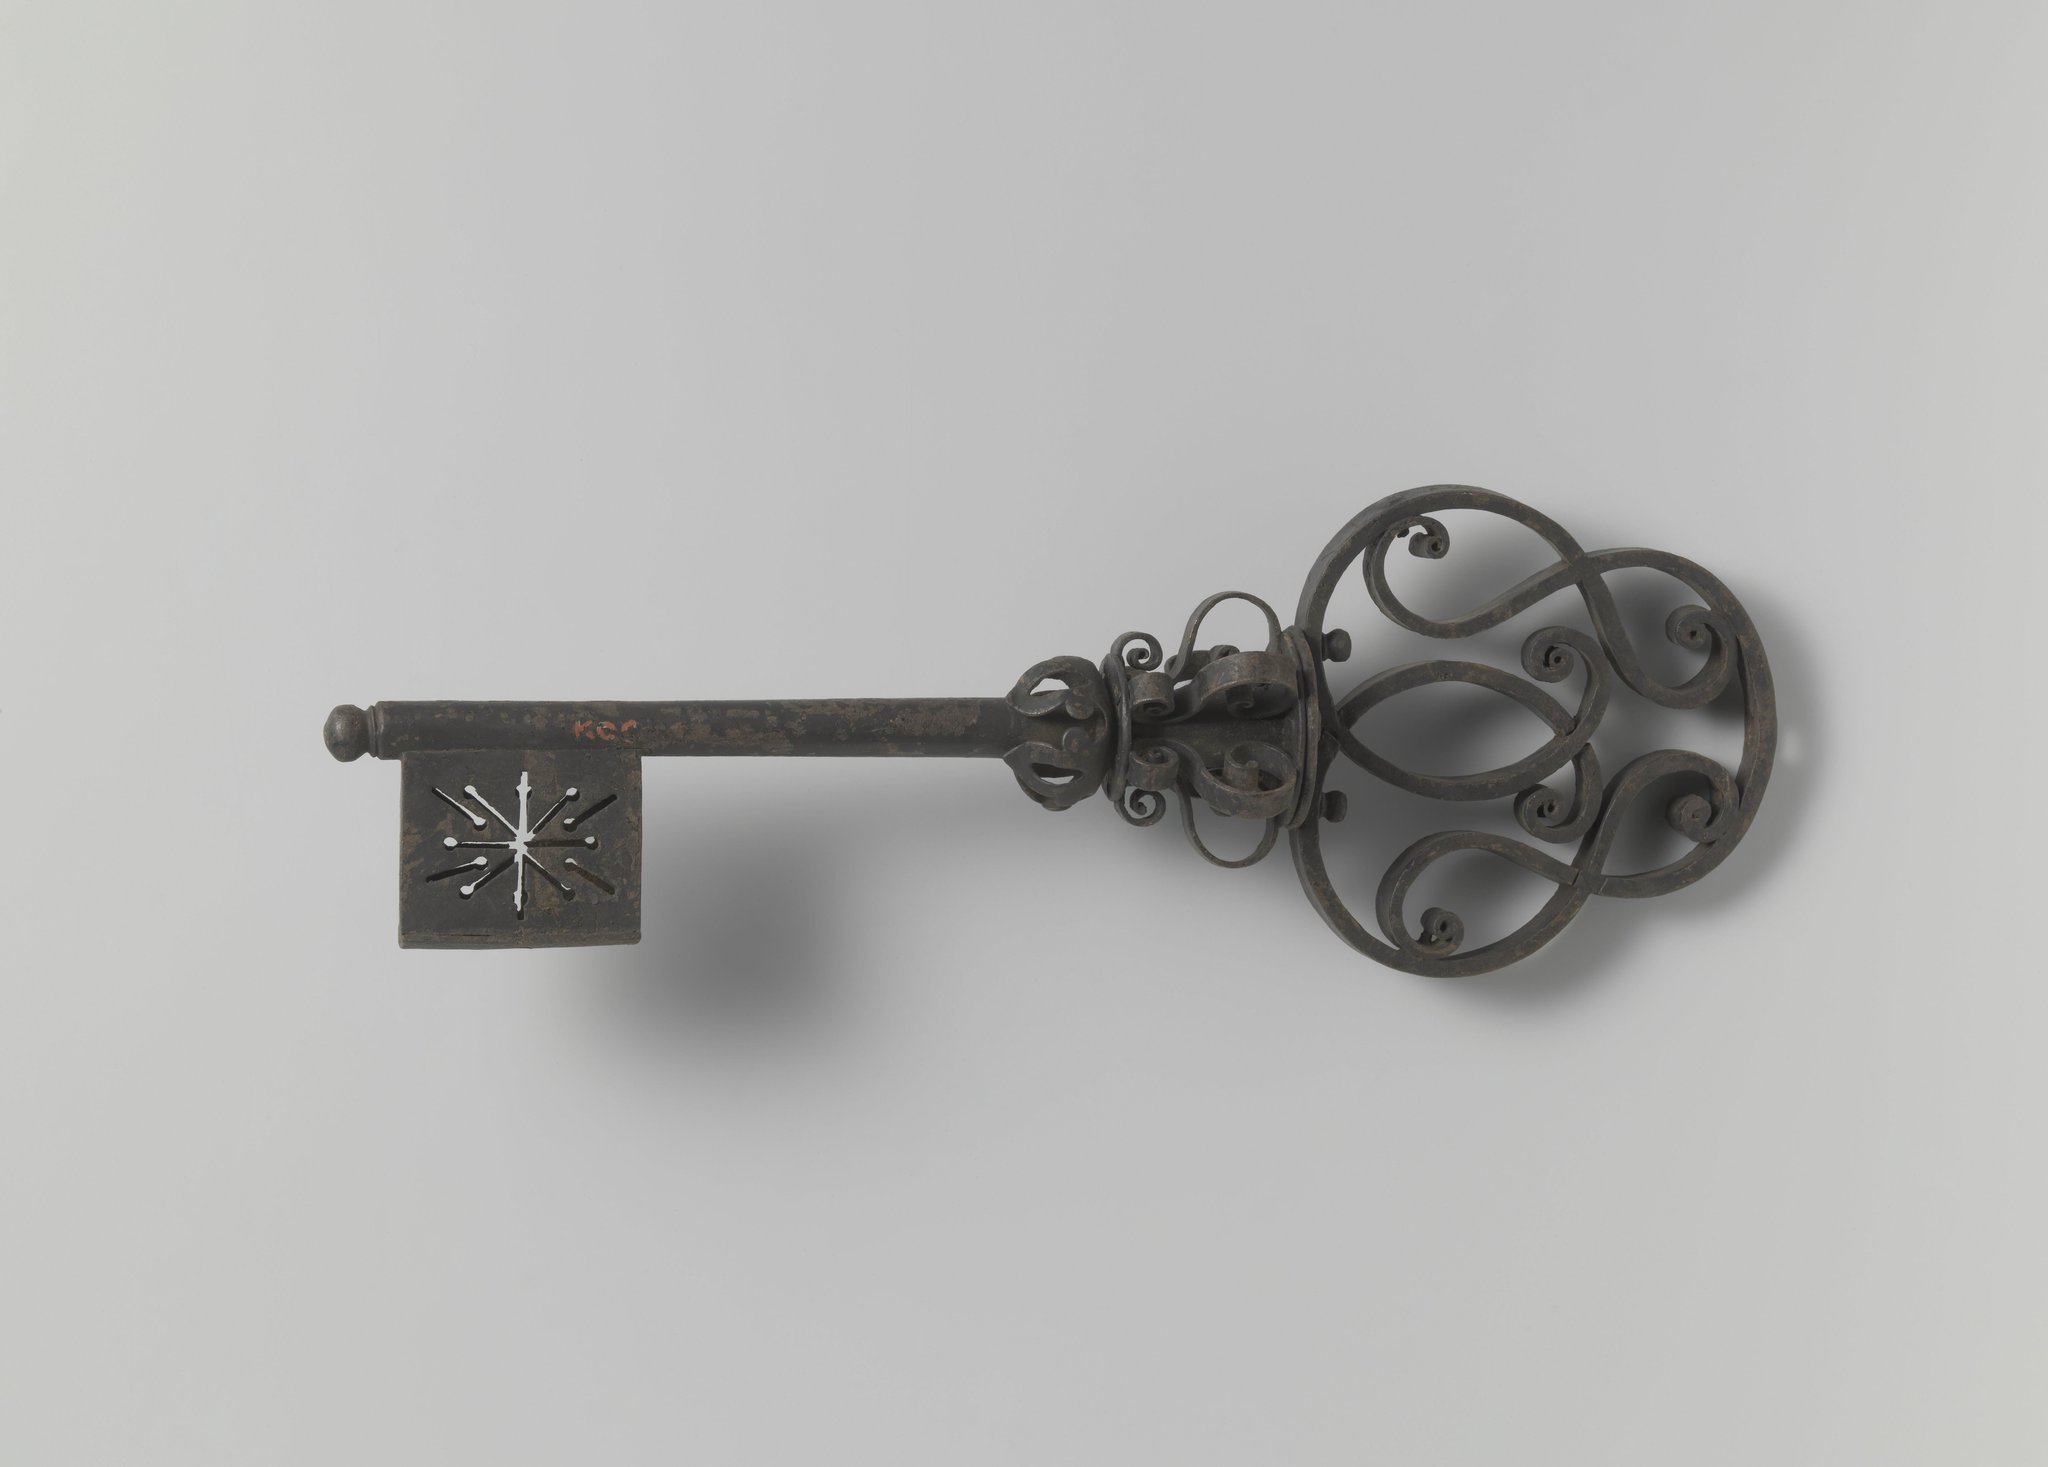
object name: uithangteken, uithangbord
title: Uithangteken in de vorm van een sleutel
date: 1000-2000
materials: iron